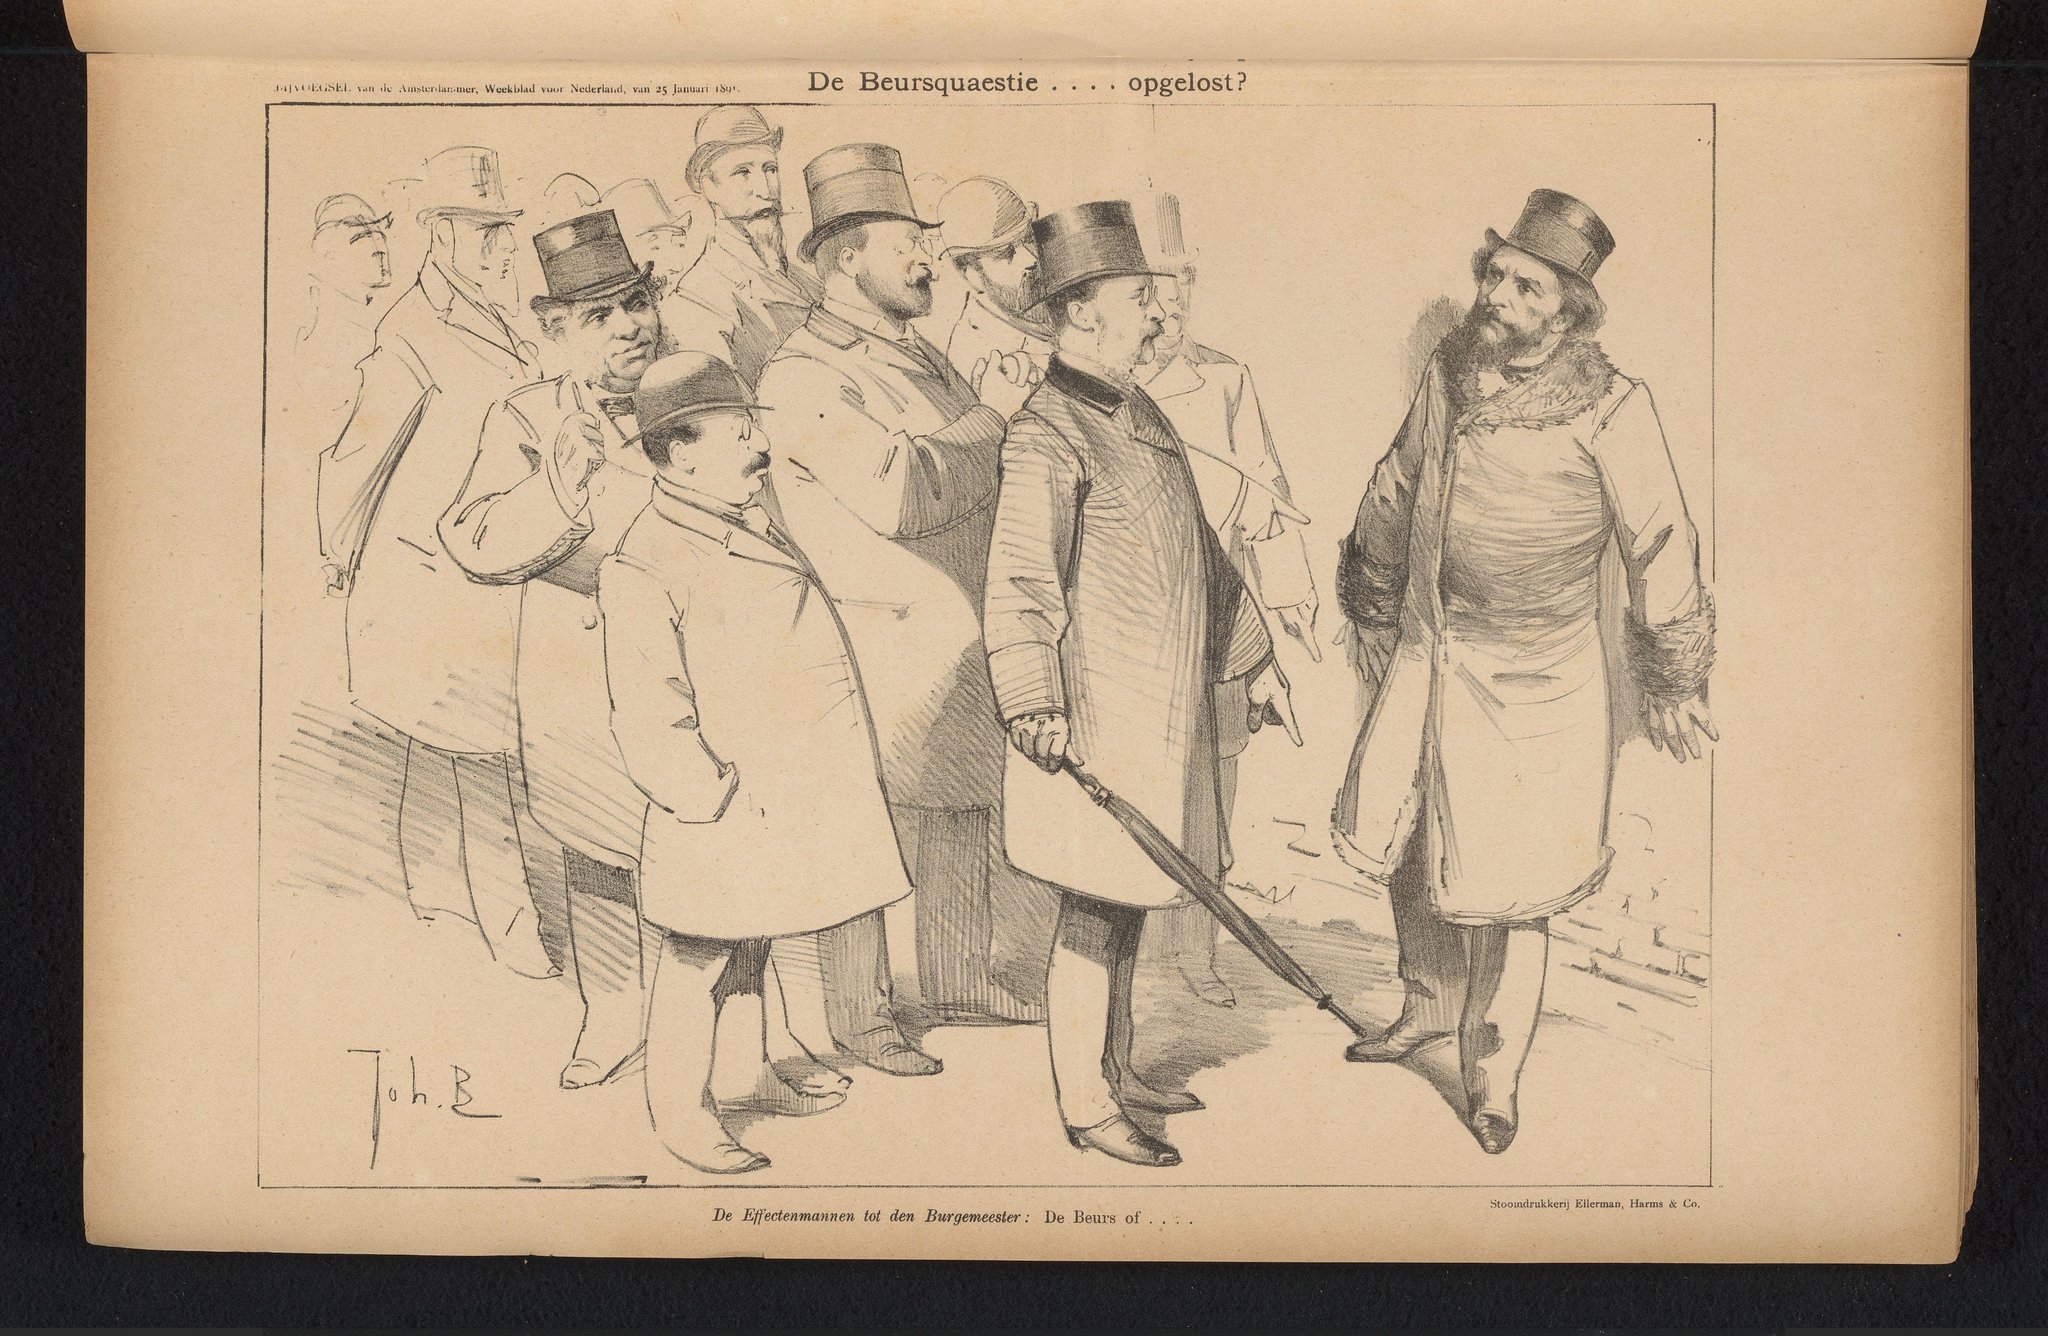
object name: cartoon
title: De Beursquaestie ... opgelost?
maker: johan braakensiek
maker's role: draughtsman, print maker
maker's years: 1858-1940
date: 1891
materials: paper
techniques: lithograph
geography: netherlands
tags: mayor, gijsbert van tienhoven, amsterdam, mayor, burgomaster, stock exchange, stock-market, political caricatures and satires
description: Een groep beurshandelaren, waaronder A.C. Wertheim, dringt de Amsterdamse burgemeester Gijsbert van Tienhoven tegen de muur en eist een beurs. Naar aanleiding van de nieuwe beurs.